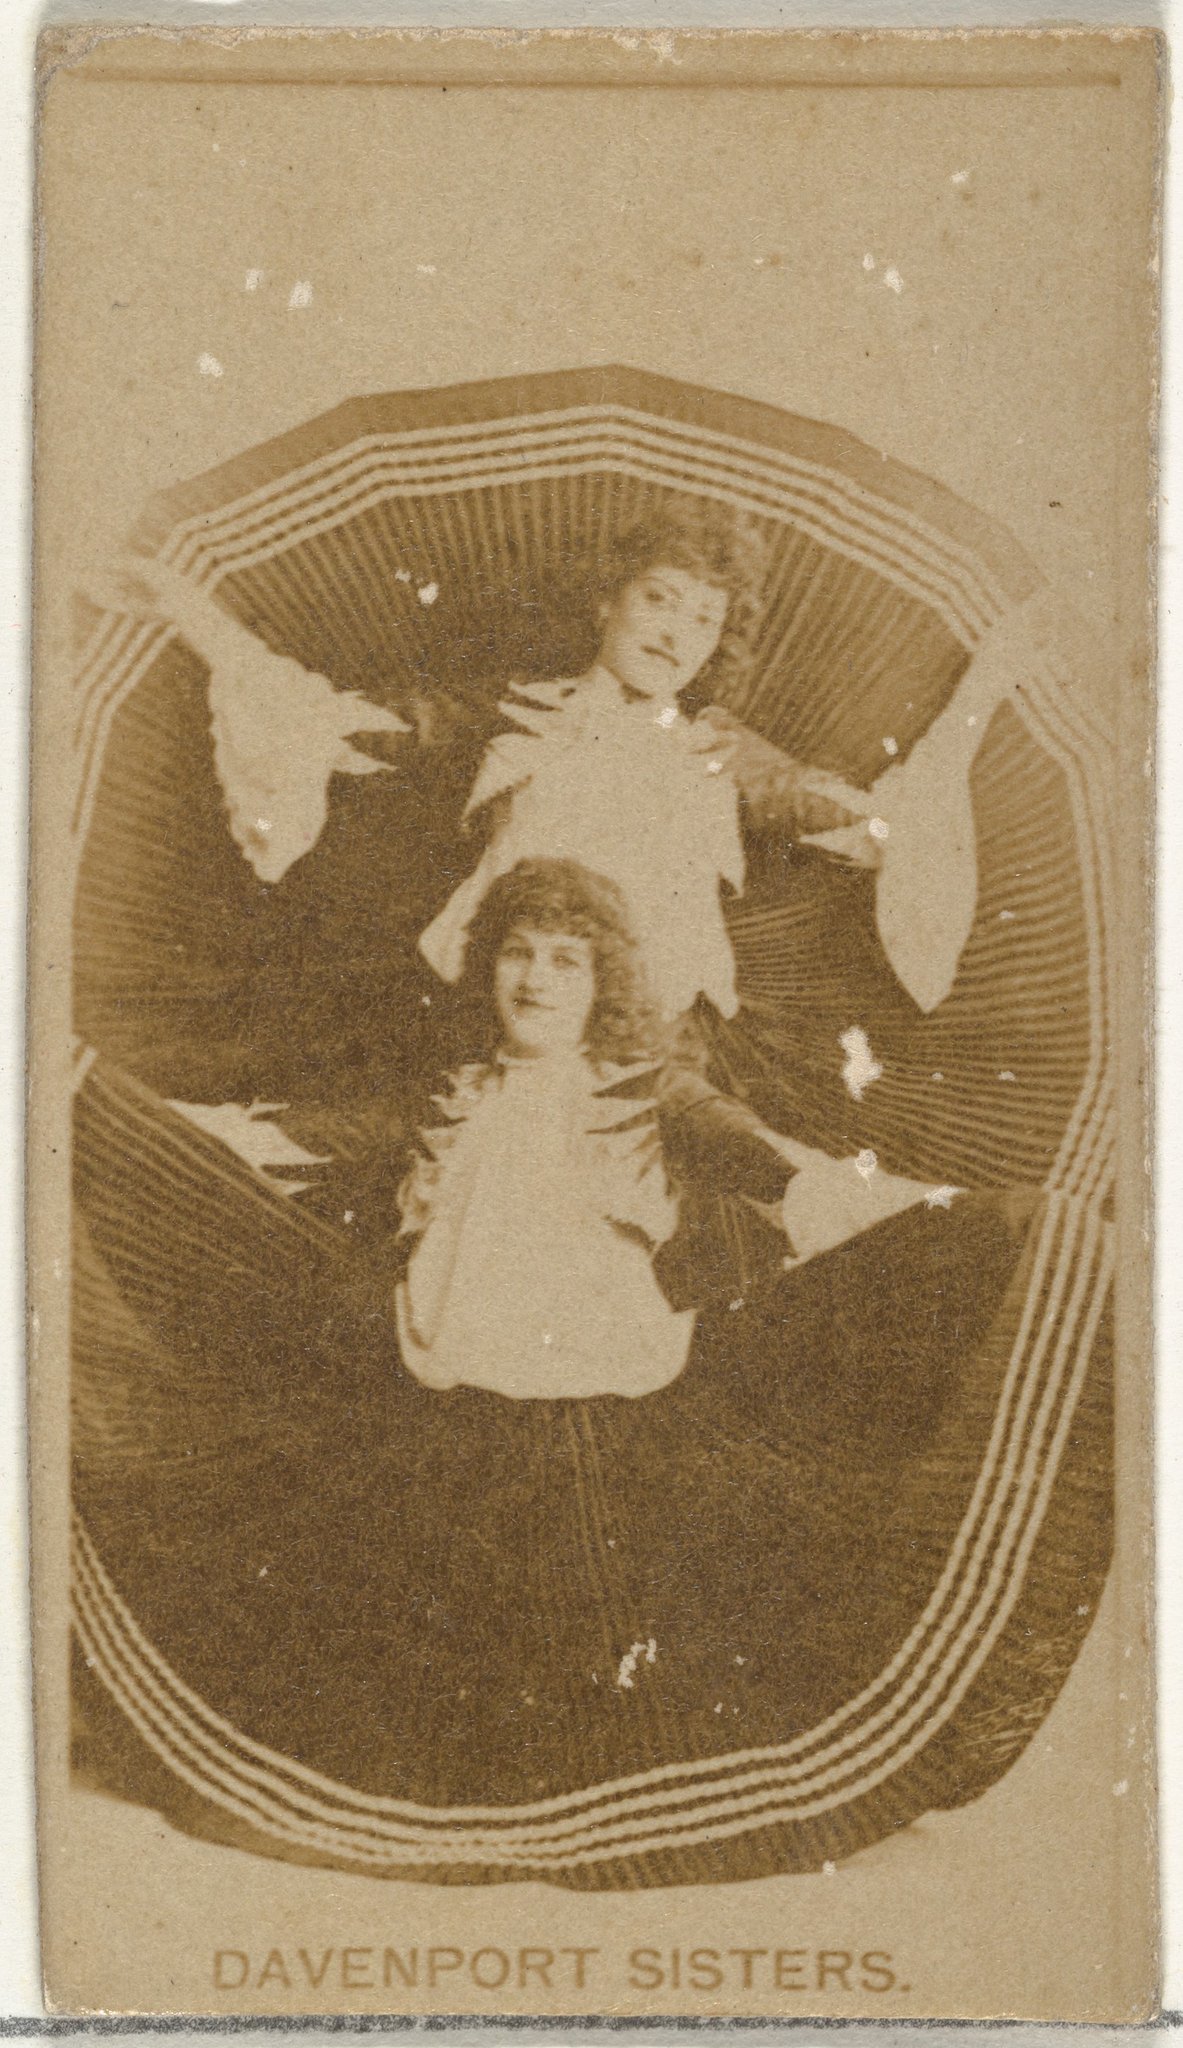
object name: photograph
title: Davenport Sisters, from the Actors and Actresses series (N145-8) issued by Duke Sons & Co. to promote Duke Cigarettes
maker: w. duke, sons & co.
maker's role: publisher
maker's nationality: american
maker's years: 1870-1920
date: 1891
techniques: albumen silver print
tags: portraits,women,actresses